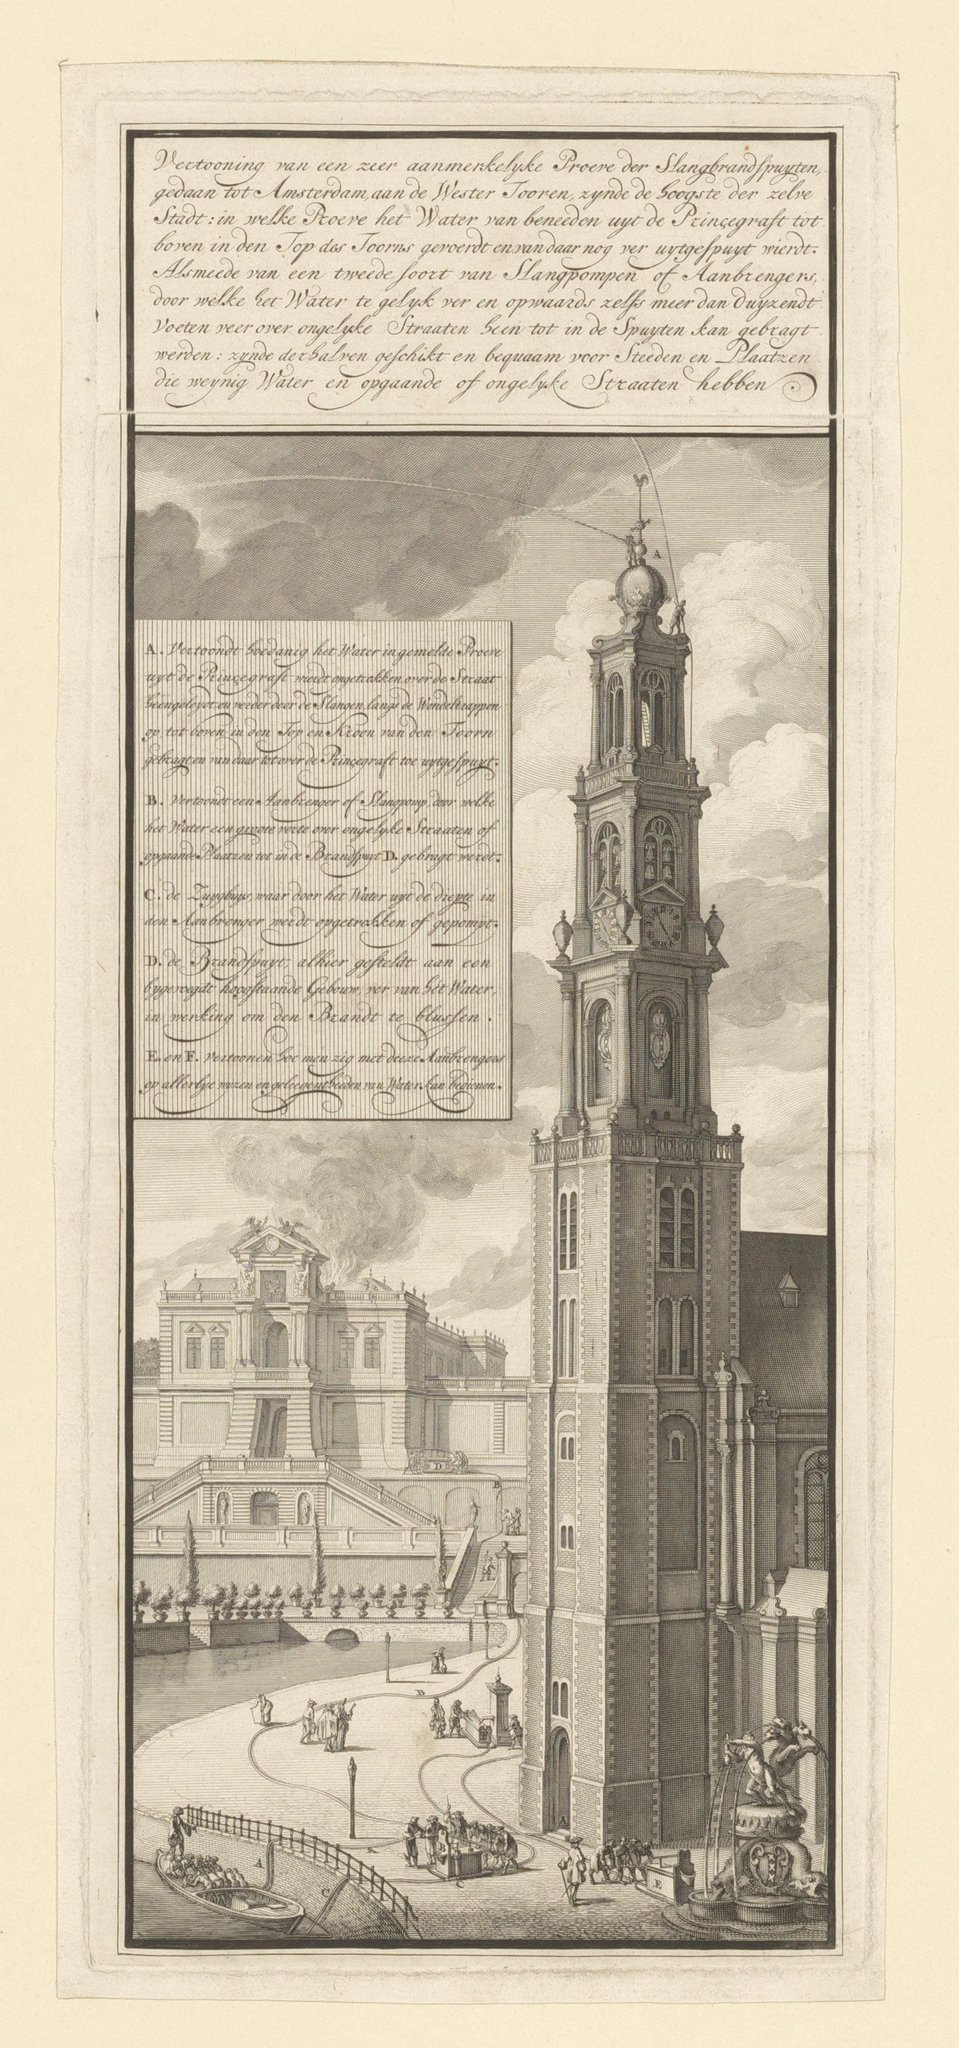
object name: print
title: Demonstratie van de slangbrandspuiten op de Westertoren te Amsterdam, ca. 1700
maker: laurens scherm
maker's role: draughtsman, print maker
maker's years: 1671-1702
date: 1735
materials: paper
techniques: engraving, etching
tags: fire-hose, fire-extinguishing equipment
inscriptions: collector's mark: Lugt 1641, stamp, stamp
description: Demonstratie van het gebruik van de slangbrandspuiten op de Westertoren te Amsterdam, ca. 1700. Op de achtergrond een brand in een paleis. In een cartouche links de verklaring van de letters A-F in het Nederlands. Boven de plaat is een tweede plaat met tekst afgedrukt. Plaat 24 in de herdruk van het Brandspuitenboek van Jan van der Heyden uit 1735. Onderwerpsrubrieken binnen de Atlas Zeden en Gewoonten: Regeering, Brandwezen.